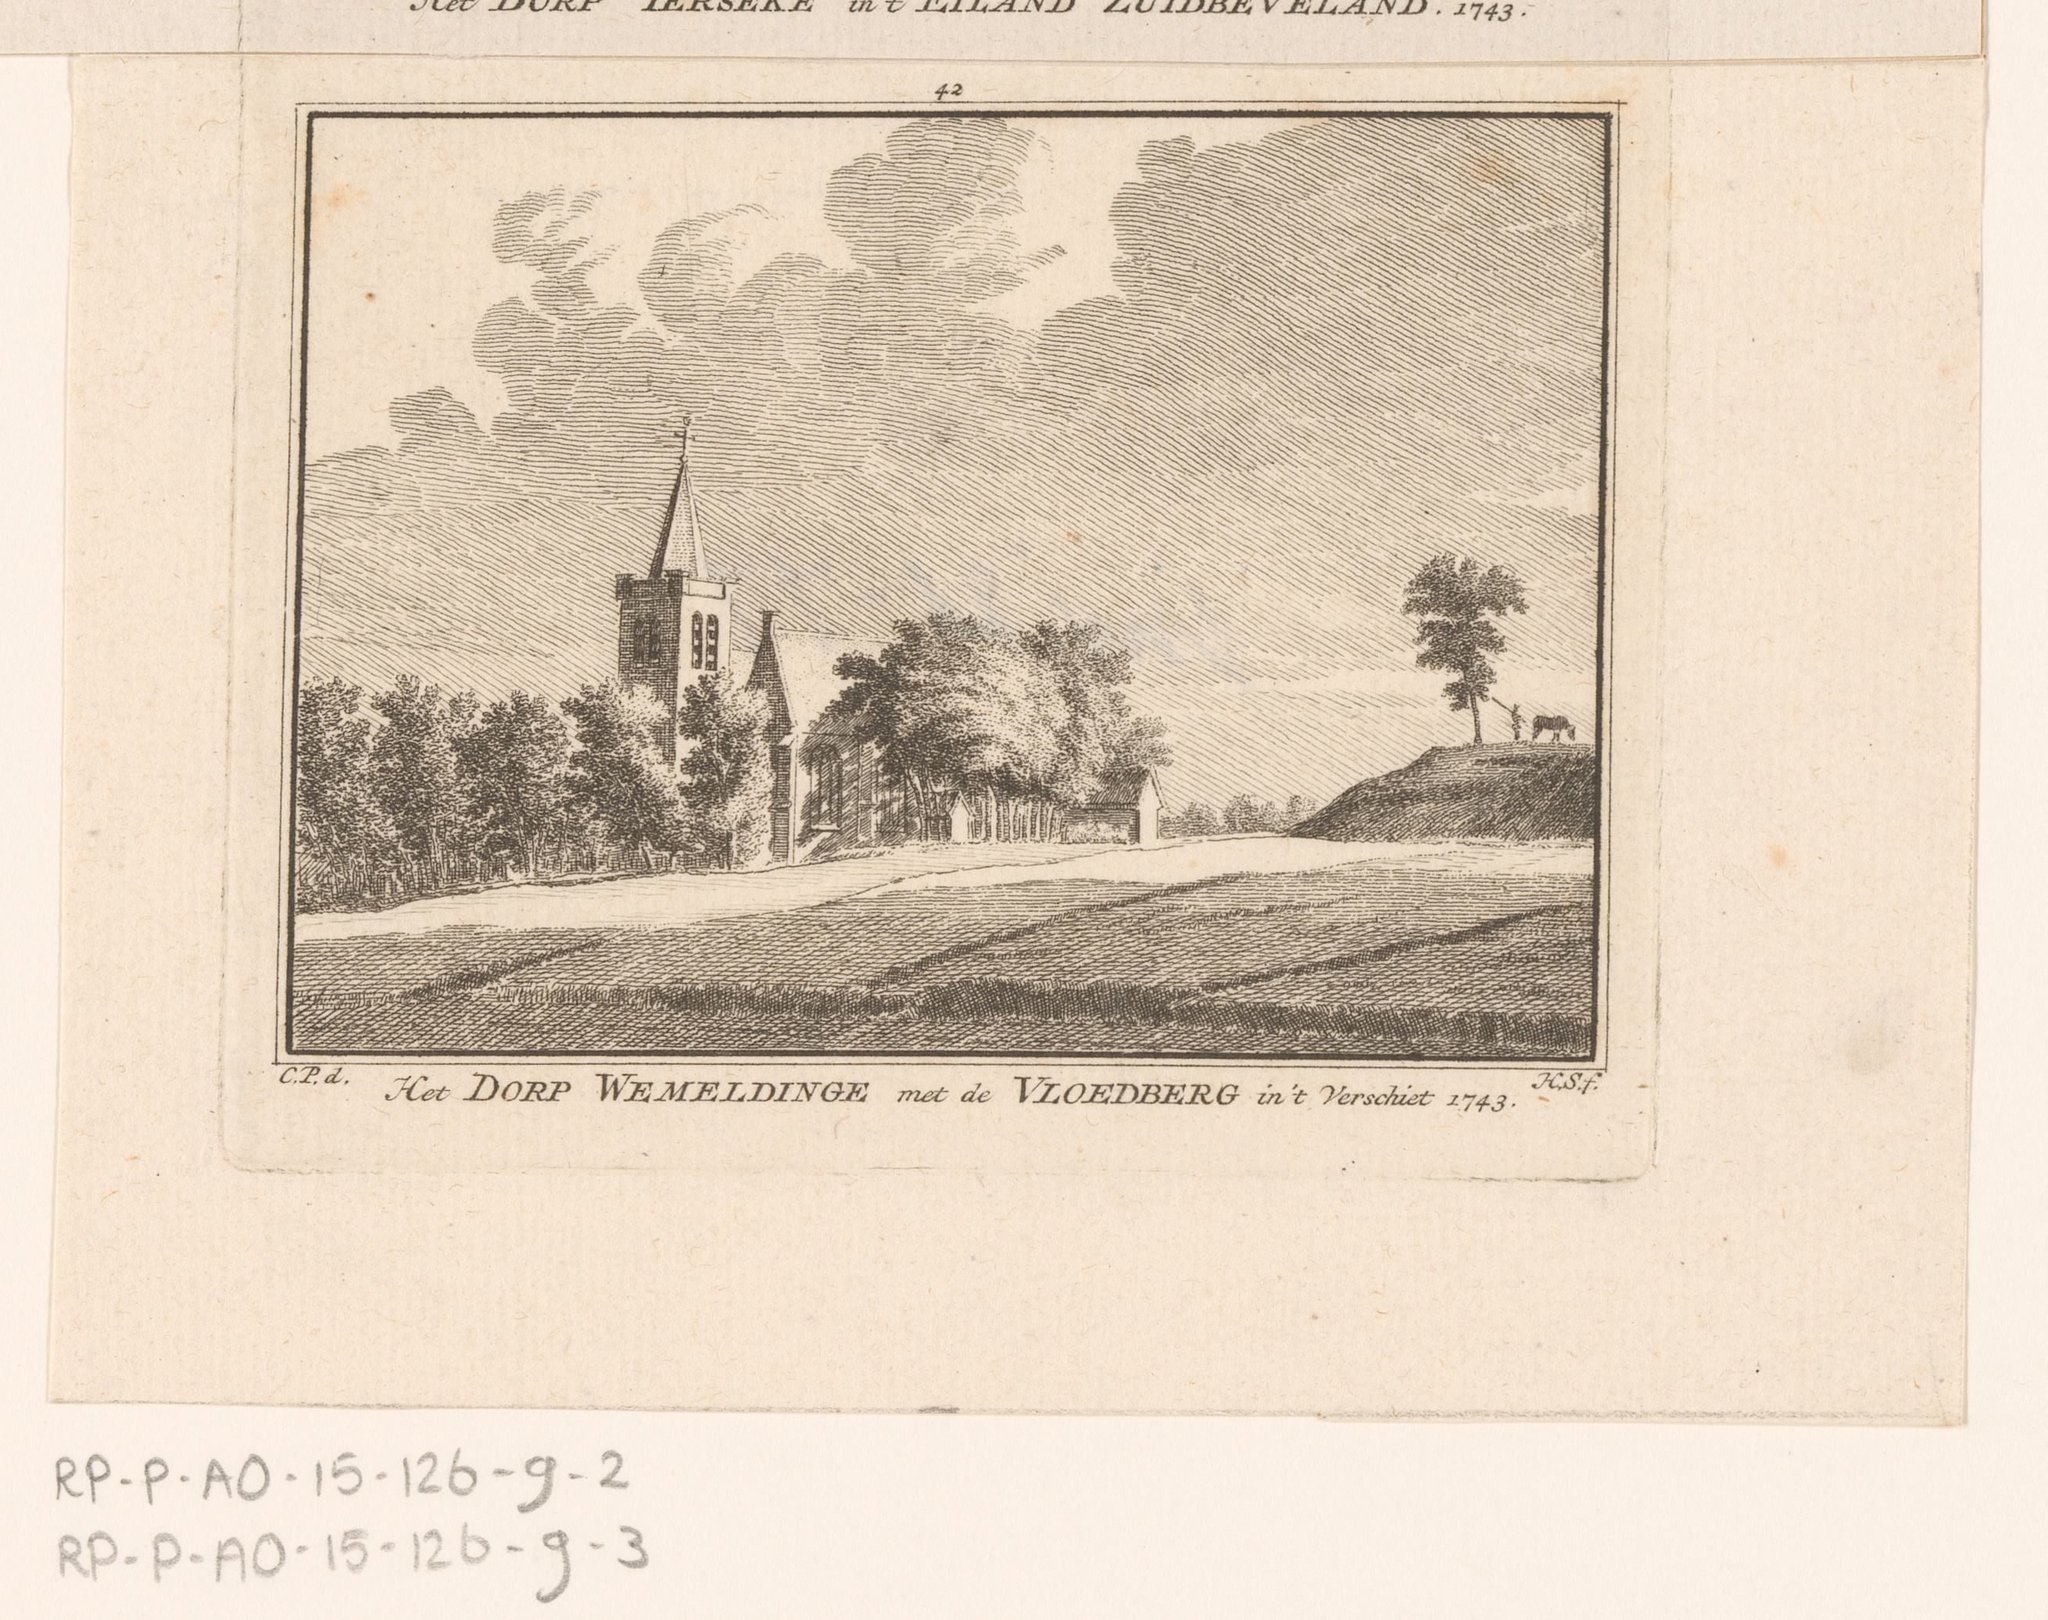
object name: print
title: Gezicht op Wemeldinge, 1743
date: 1754-1792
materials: paper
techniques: etching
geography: haarlem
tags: prospect of village, silhouette of village, church (exterior)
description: Prent ook gebruikt in: Het verheerlykt Nederland of kabinet van hedendaagsche gezigten van steden, dorpen (…). 9 delen. Amsterdam: Isaak Tirion en weduwe Isaak Tirion, 1745-1774, dl. 5 (1754), ill. 42. Of in: Nederlandsche tafereelen; of eene keurige verzameling van negen honderd fraaije gezigten van steden, dorpen, sloten, oudheden [….]. 9 delen. Amsterdam: Jan de Groot, 1792, dl. 5, ill. 42.